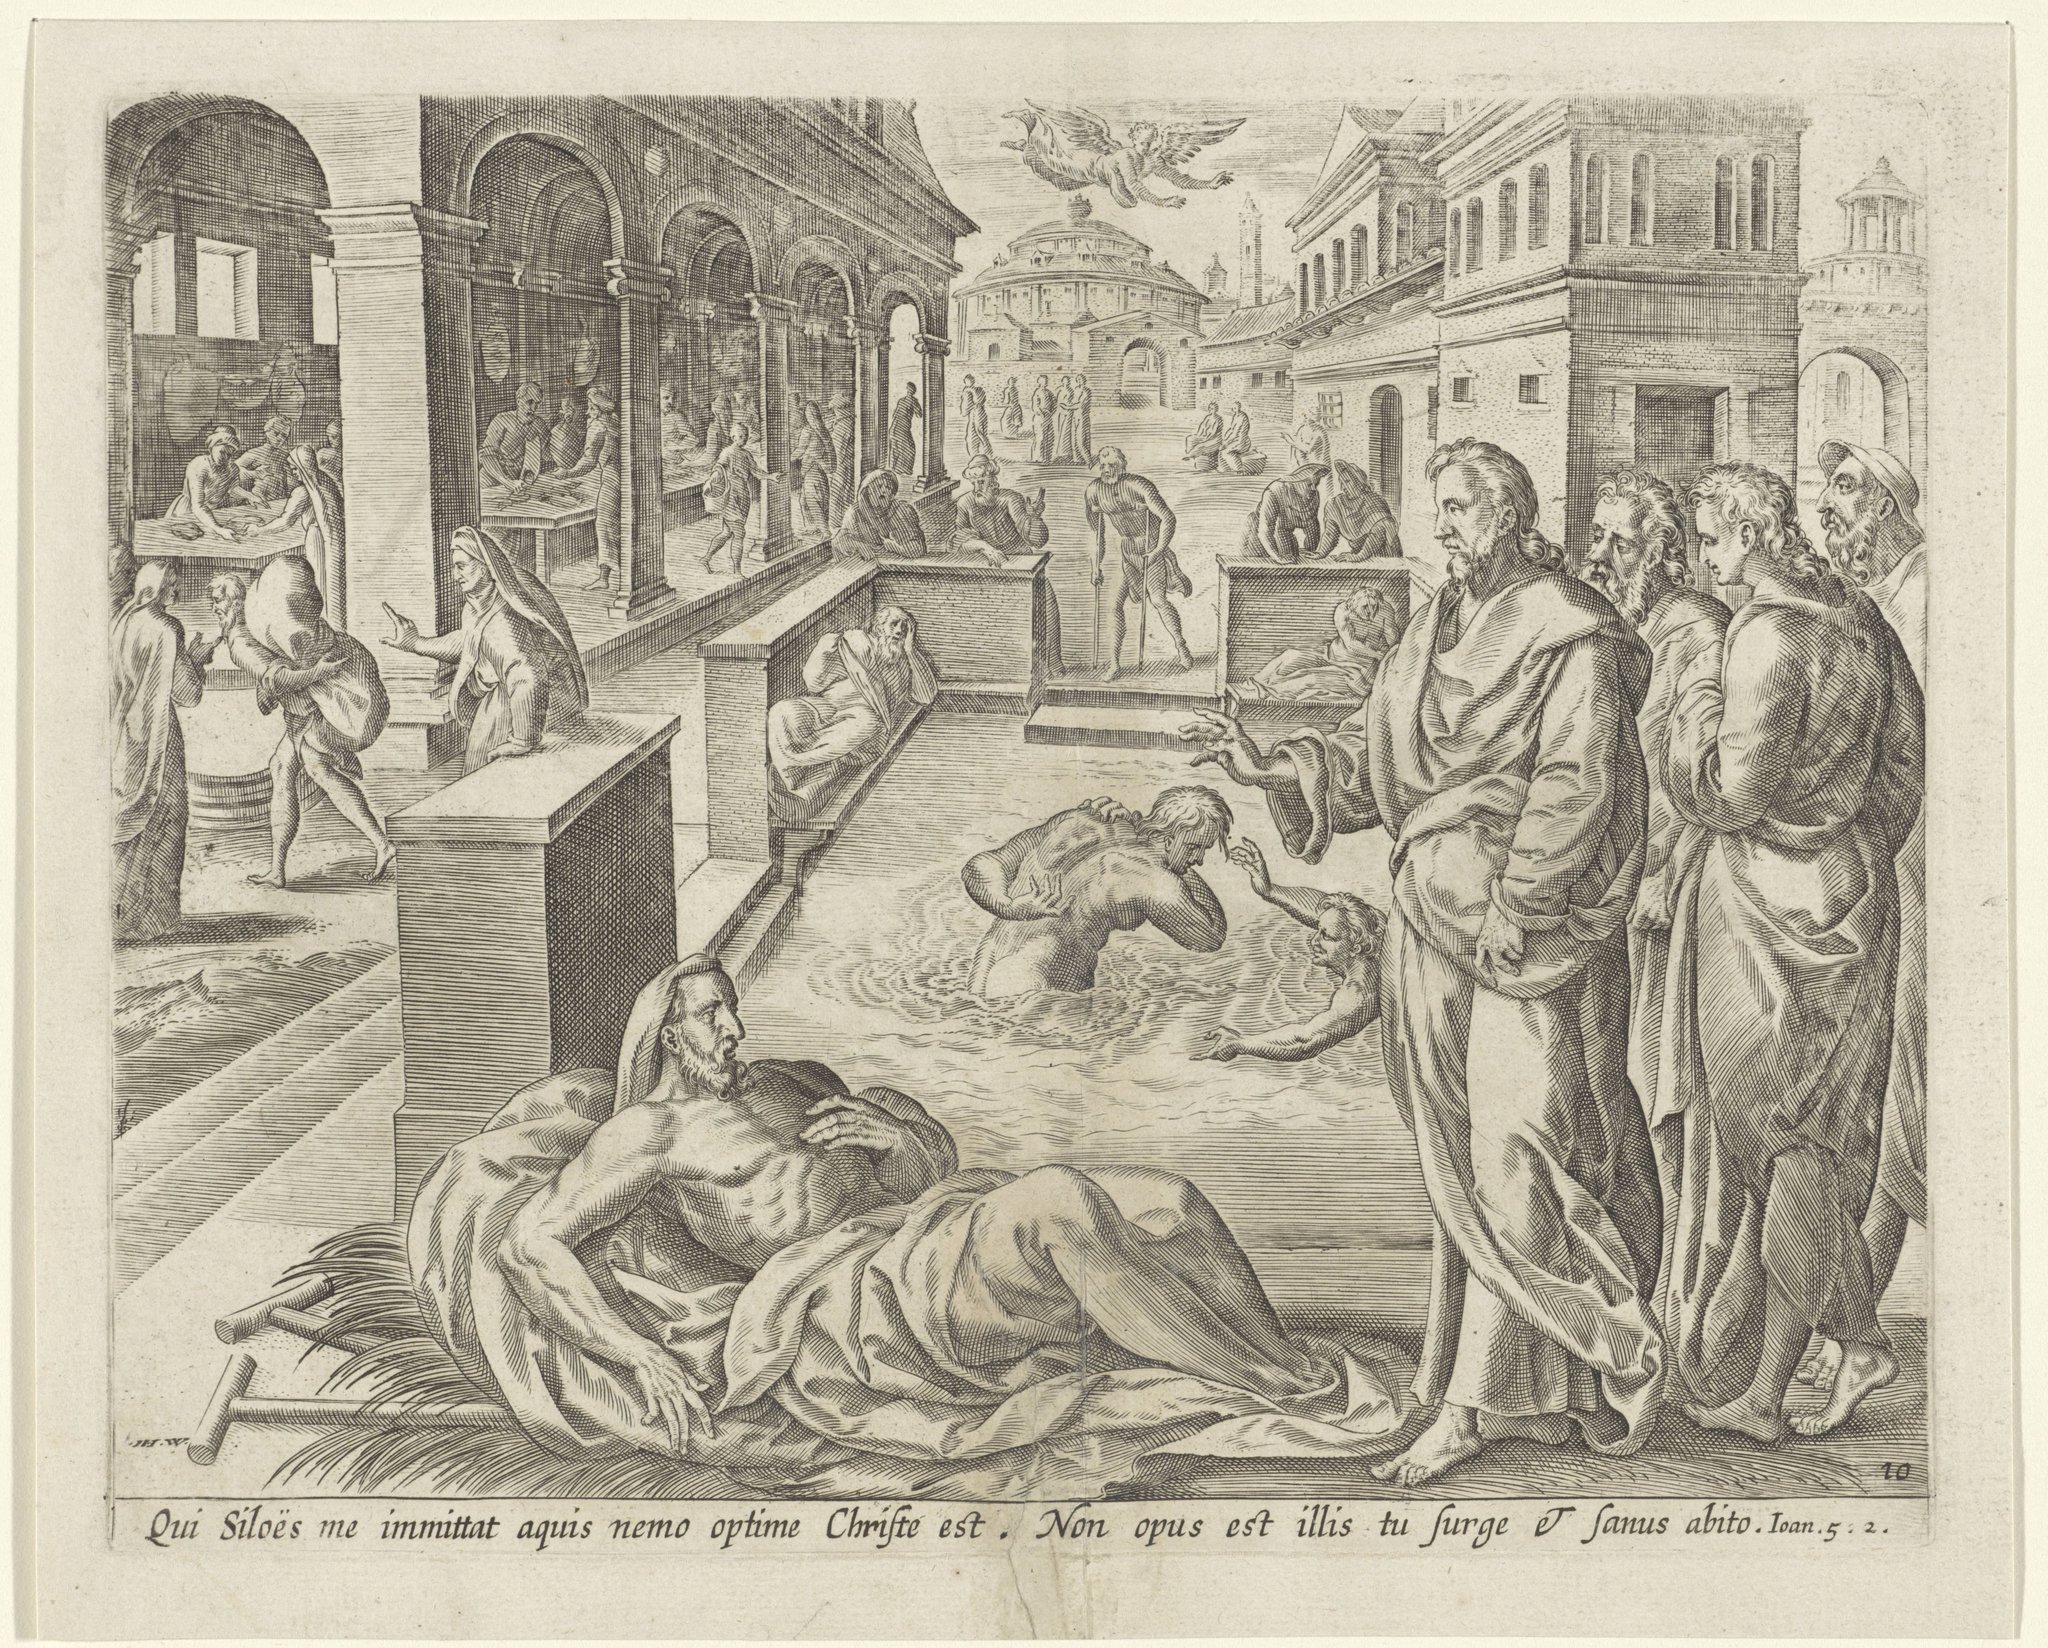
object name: print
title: Christus geneest een man bij het bad van Betesda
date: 1585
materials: paper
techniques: engraving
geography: amsterdam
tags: disabilities, deformations, christ says to a paralytic man: 'rise, take up your pallet (bed)', sick people lying near the pool of bethesda ~ christ healing paralytics (john 5:1-9)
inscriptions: collector's mark: Lugt 2228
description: Genezing op sabbat. Christus geneest een man die al achtendertig jaar ziek is bij het bad van Betesda (Betzata). Een man wordt ondergedompeld in het bad. Rond het water zitten zieke en blinde mensen en mensen met beperkingen. In de lucht vliegt een engel. Onder de voorstelling een verwijzing in het Latijn naar de Bijbeltekst in Joh. 5:2.